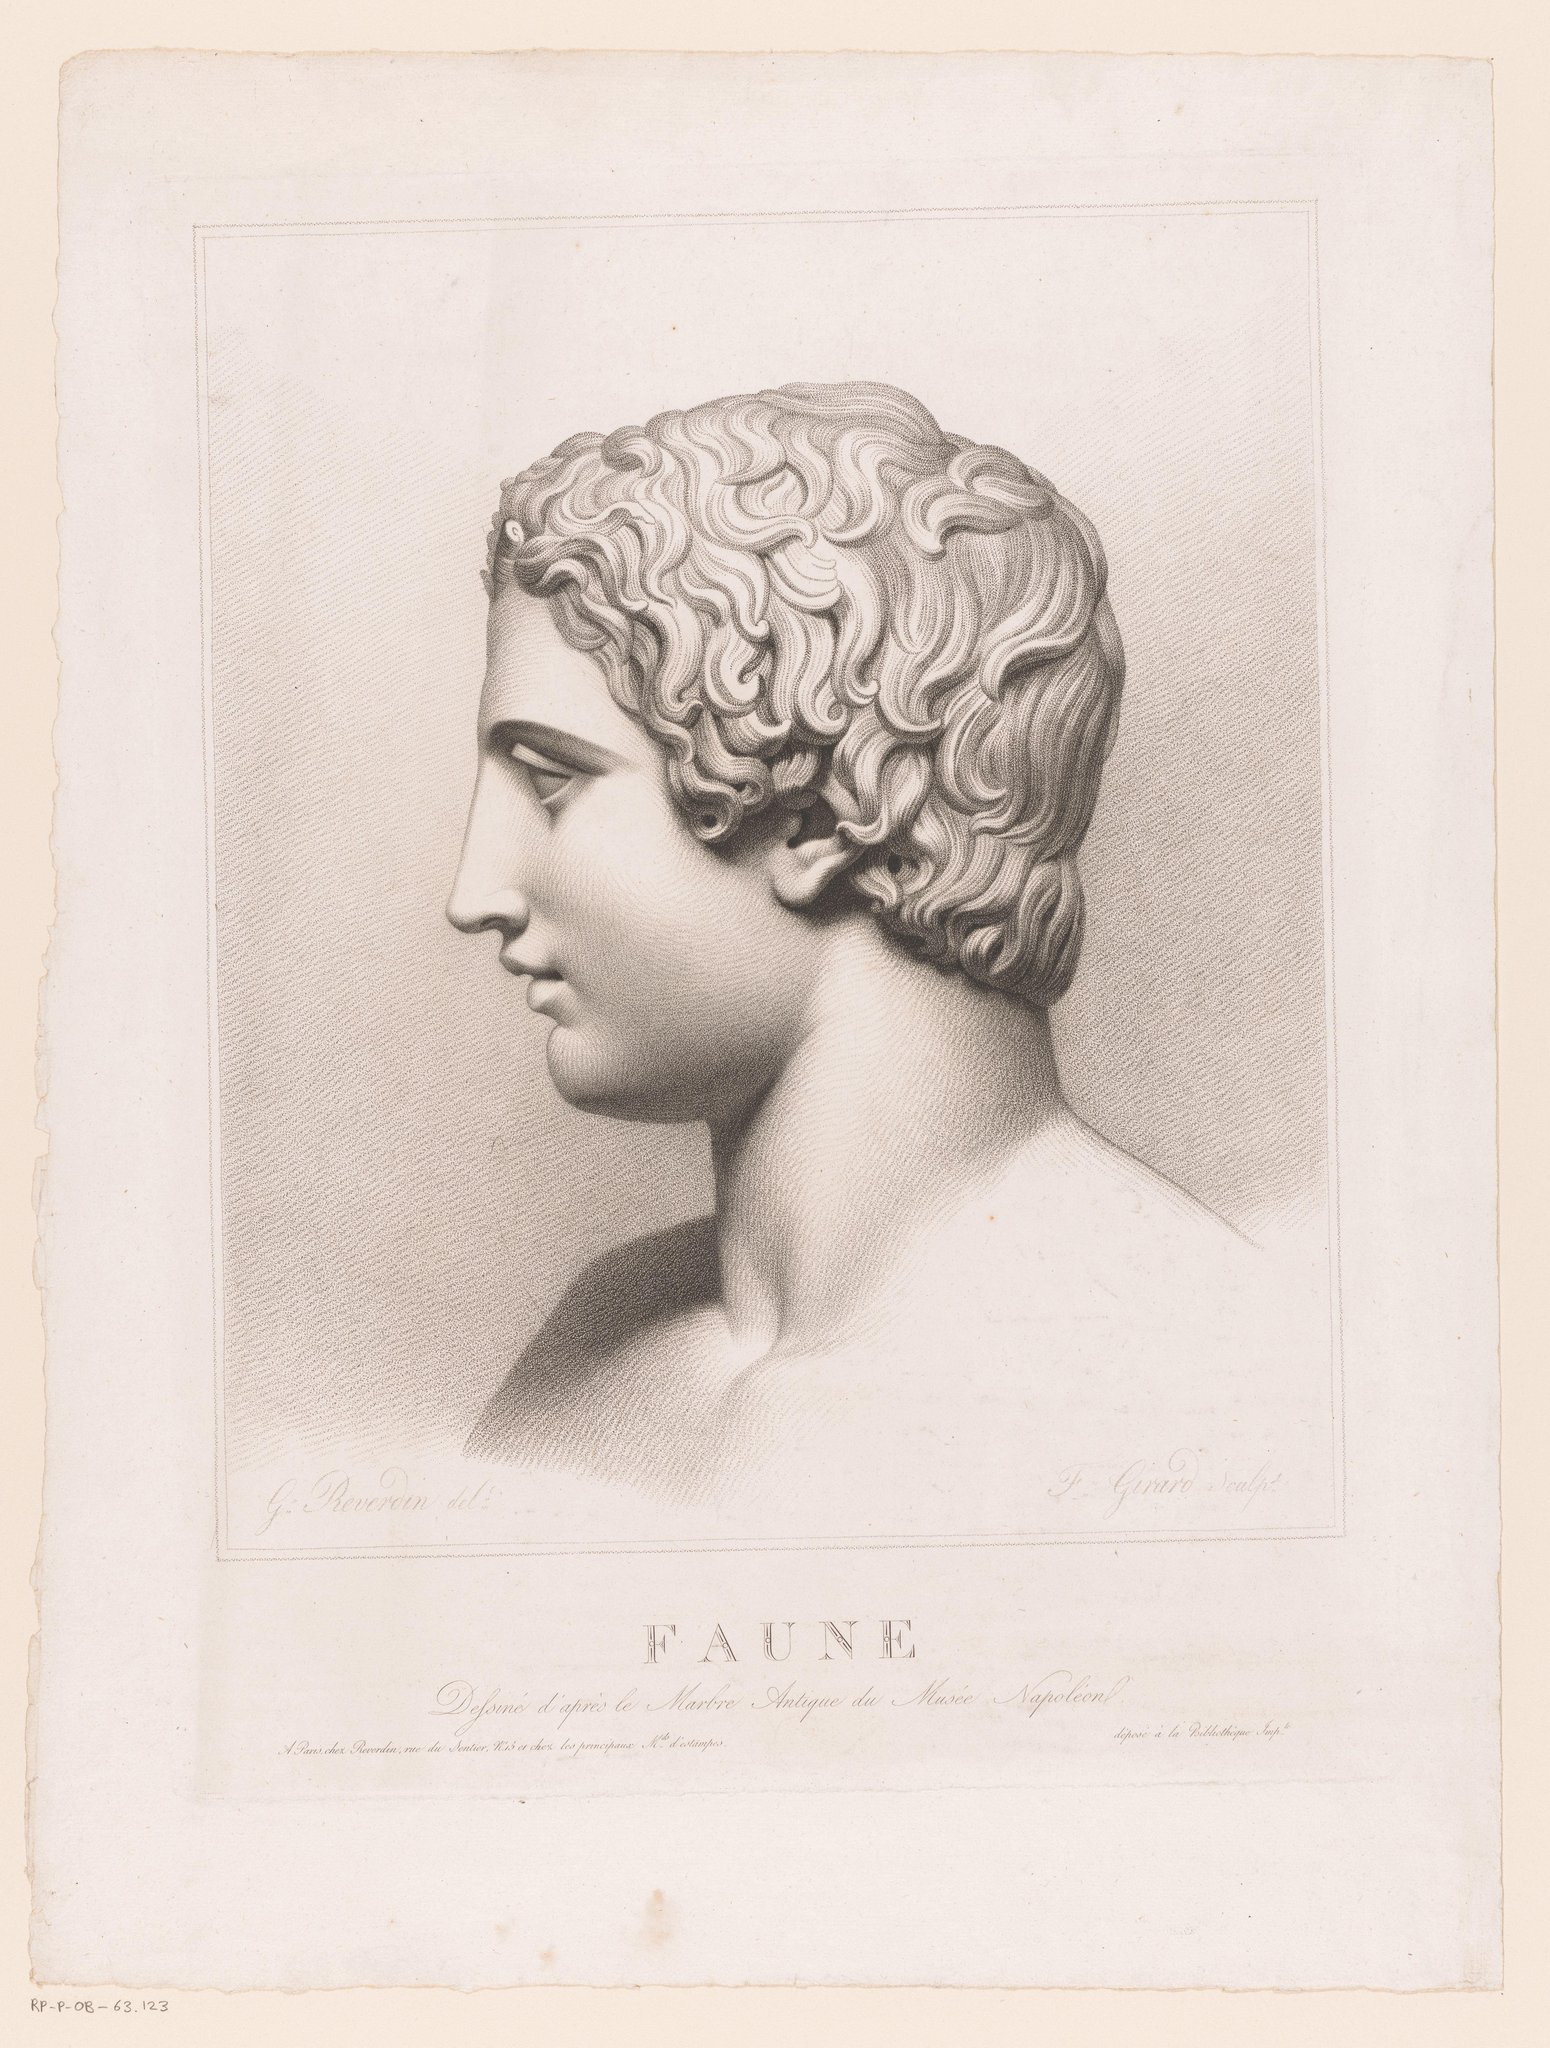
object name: print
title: Faune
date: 1797-1828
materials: paper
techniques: engraving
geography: paris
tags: satyrs, fauns, sileni, piece of sculpture, reproduction of a piece of sculpture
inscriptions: : ‘déposé à la Bibliothèque Imp.le’, collector's mark: Lugt 2228